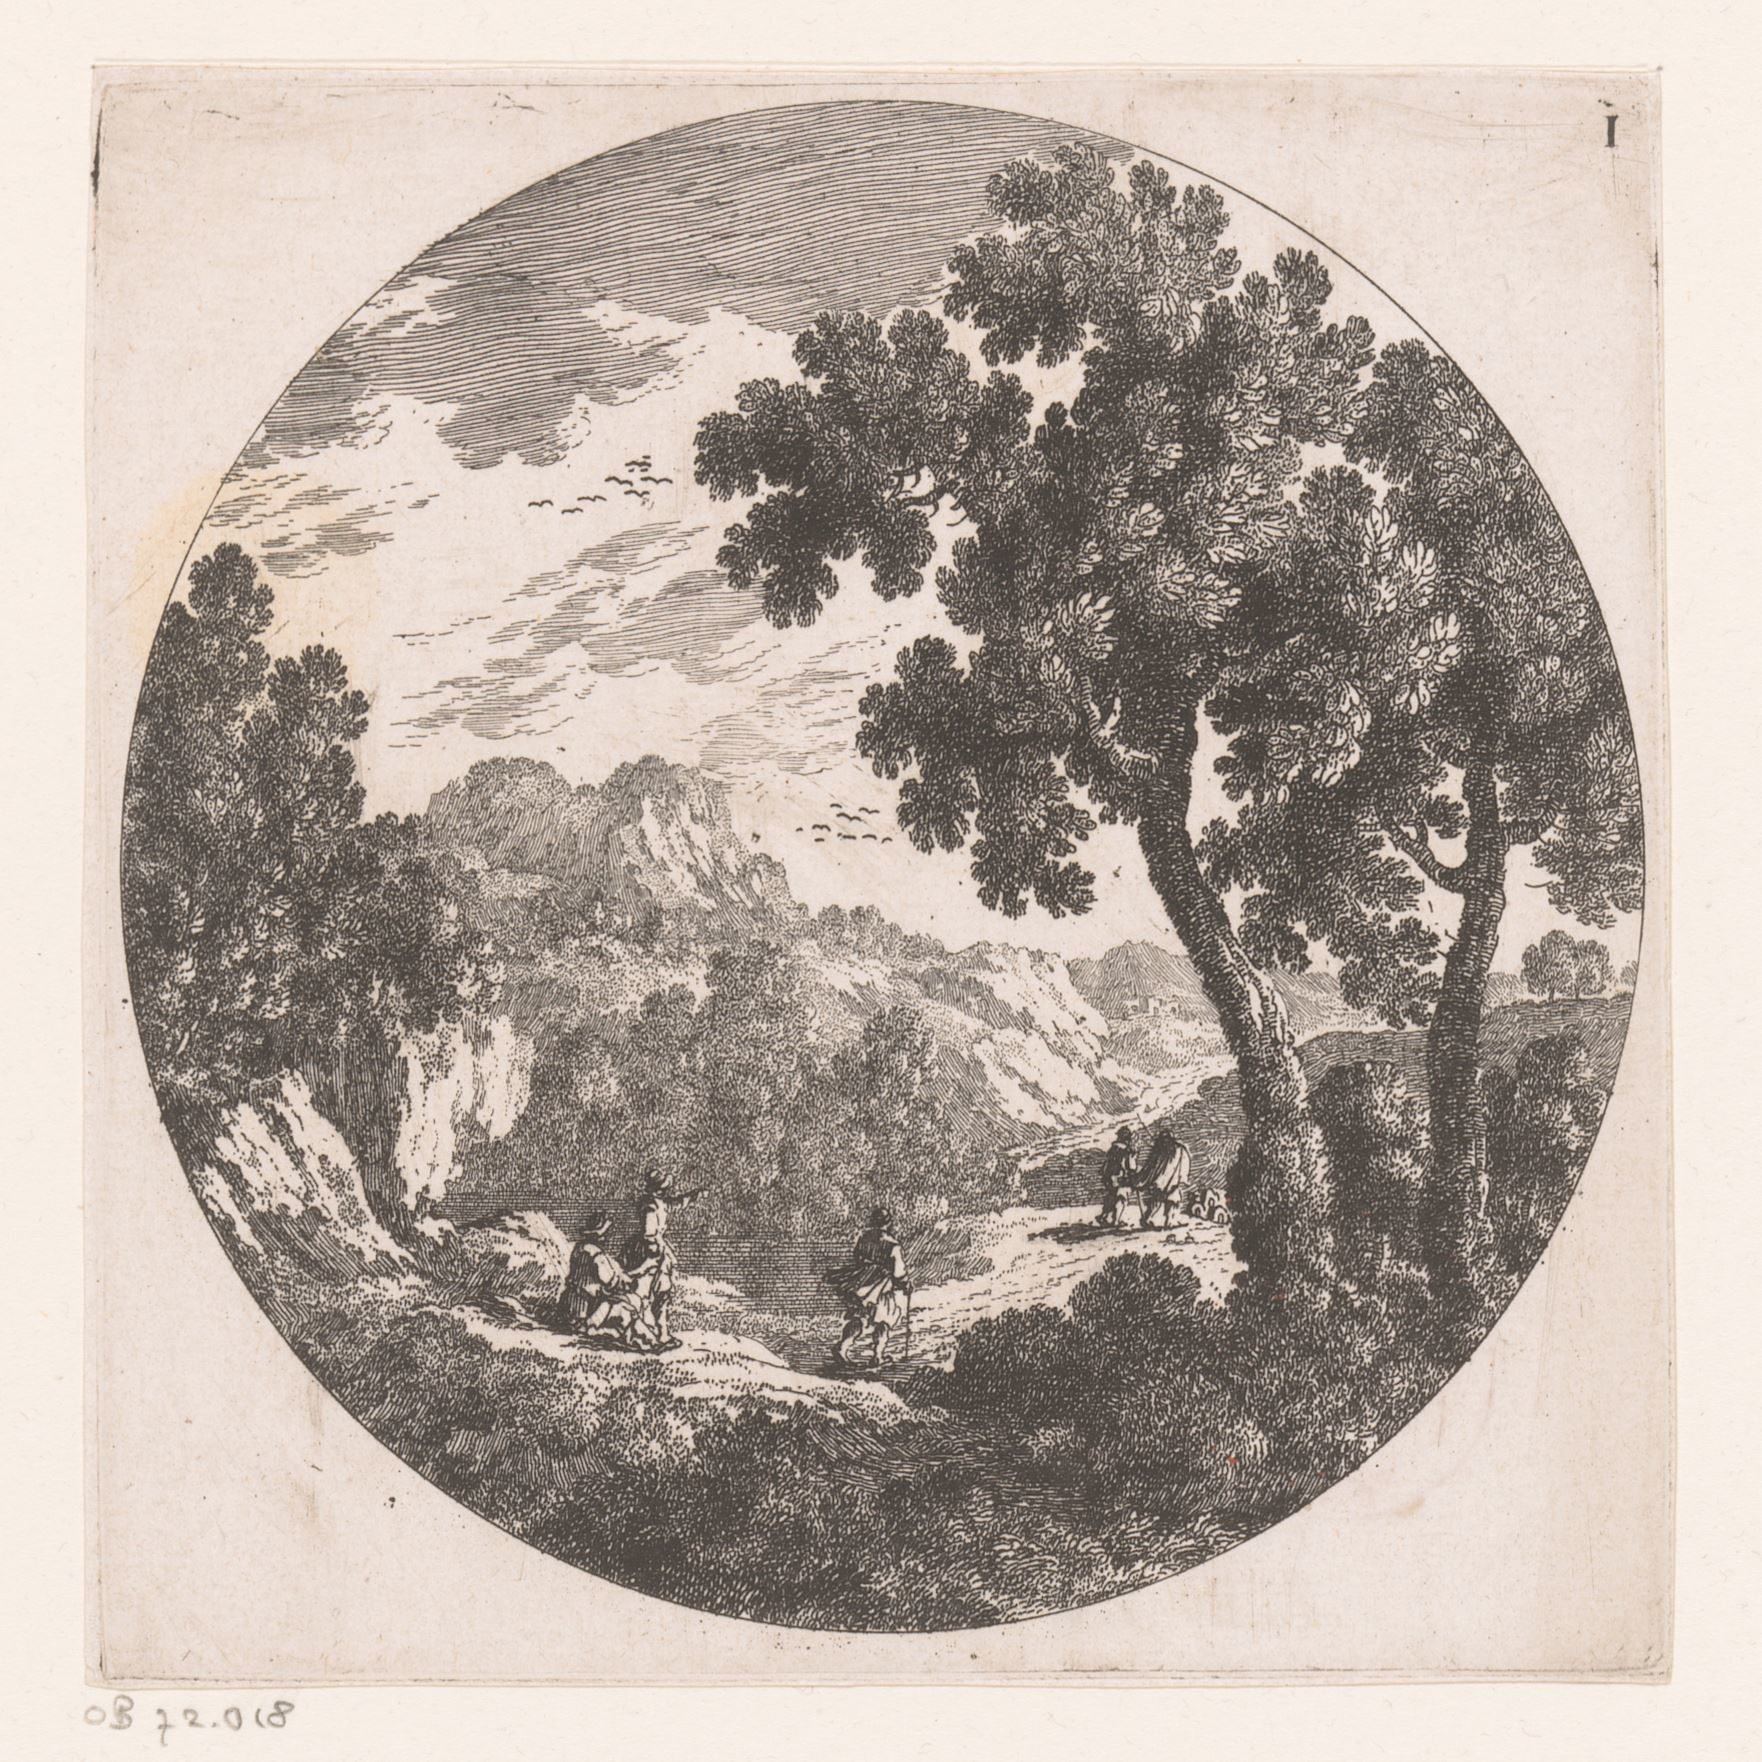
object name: print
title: Berglandschap met bomen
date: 1613-1695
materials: paper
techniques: etching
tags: trees, mountains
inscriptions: collector's mark: Lugt 240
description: Prenten met het signatuur 'Perelle' kunnen zowel door vader Gabriel als door zonen Nicolas en Adam gemaakt zijn.